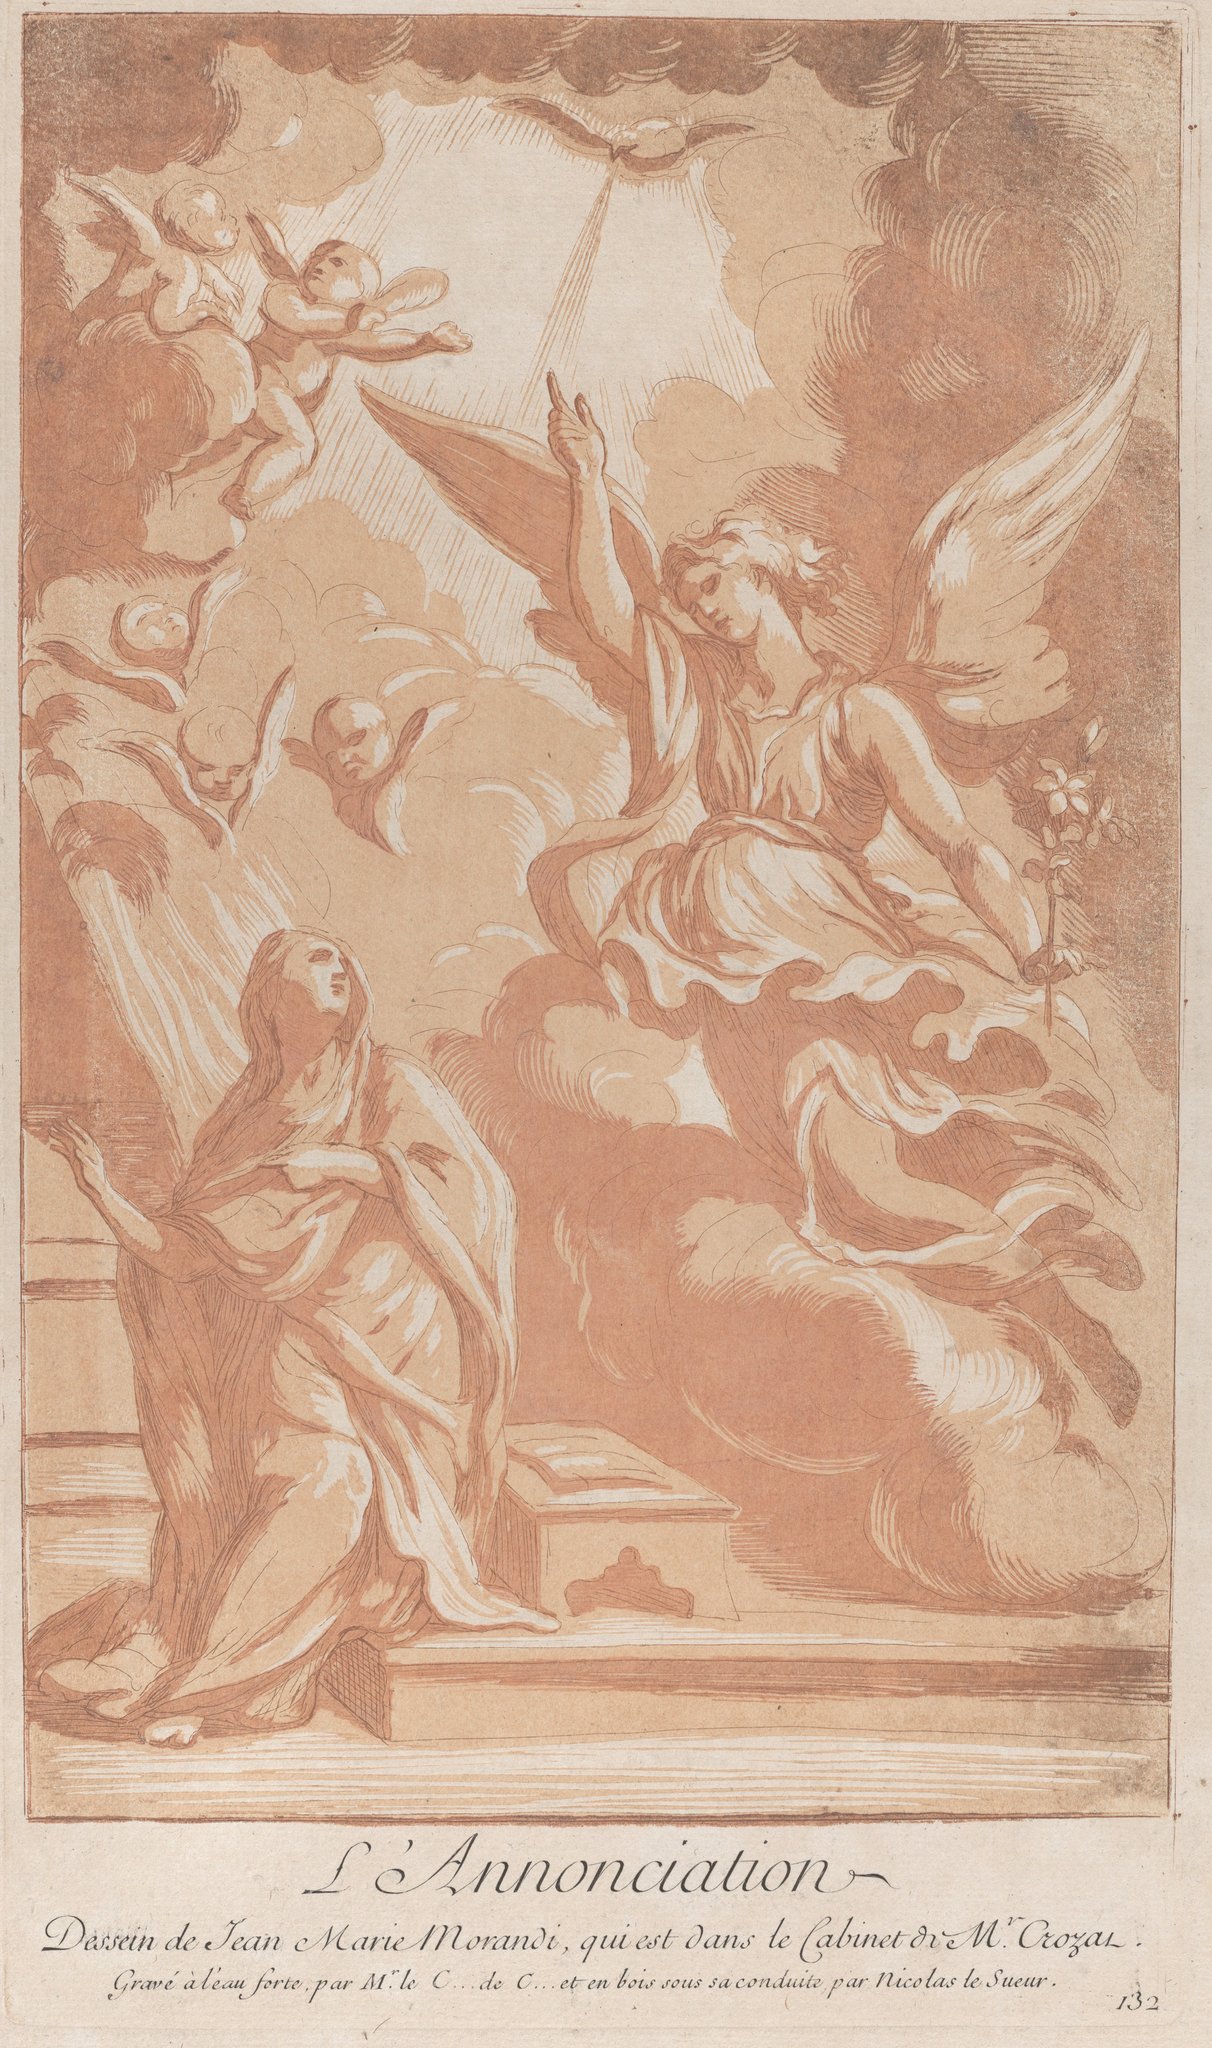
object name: print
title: The Annunciation with the Virgin kneeling at left and Gabriel appearing at right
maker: anne claude philippe de tubières, comte de caylus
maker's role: artist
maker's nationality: french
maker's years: 1692-1765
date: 1729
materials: ink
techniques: aquatint, etching